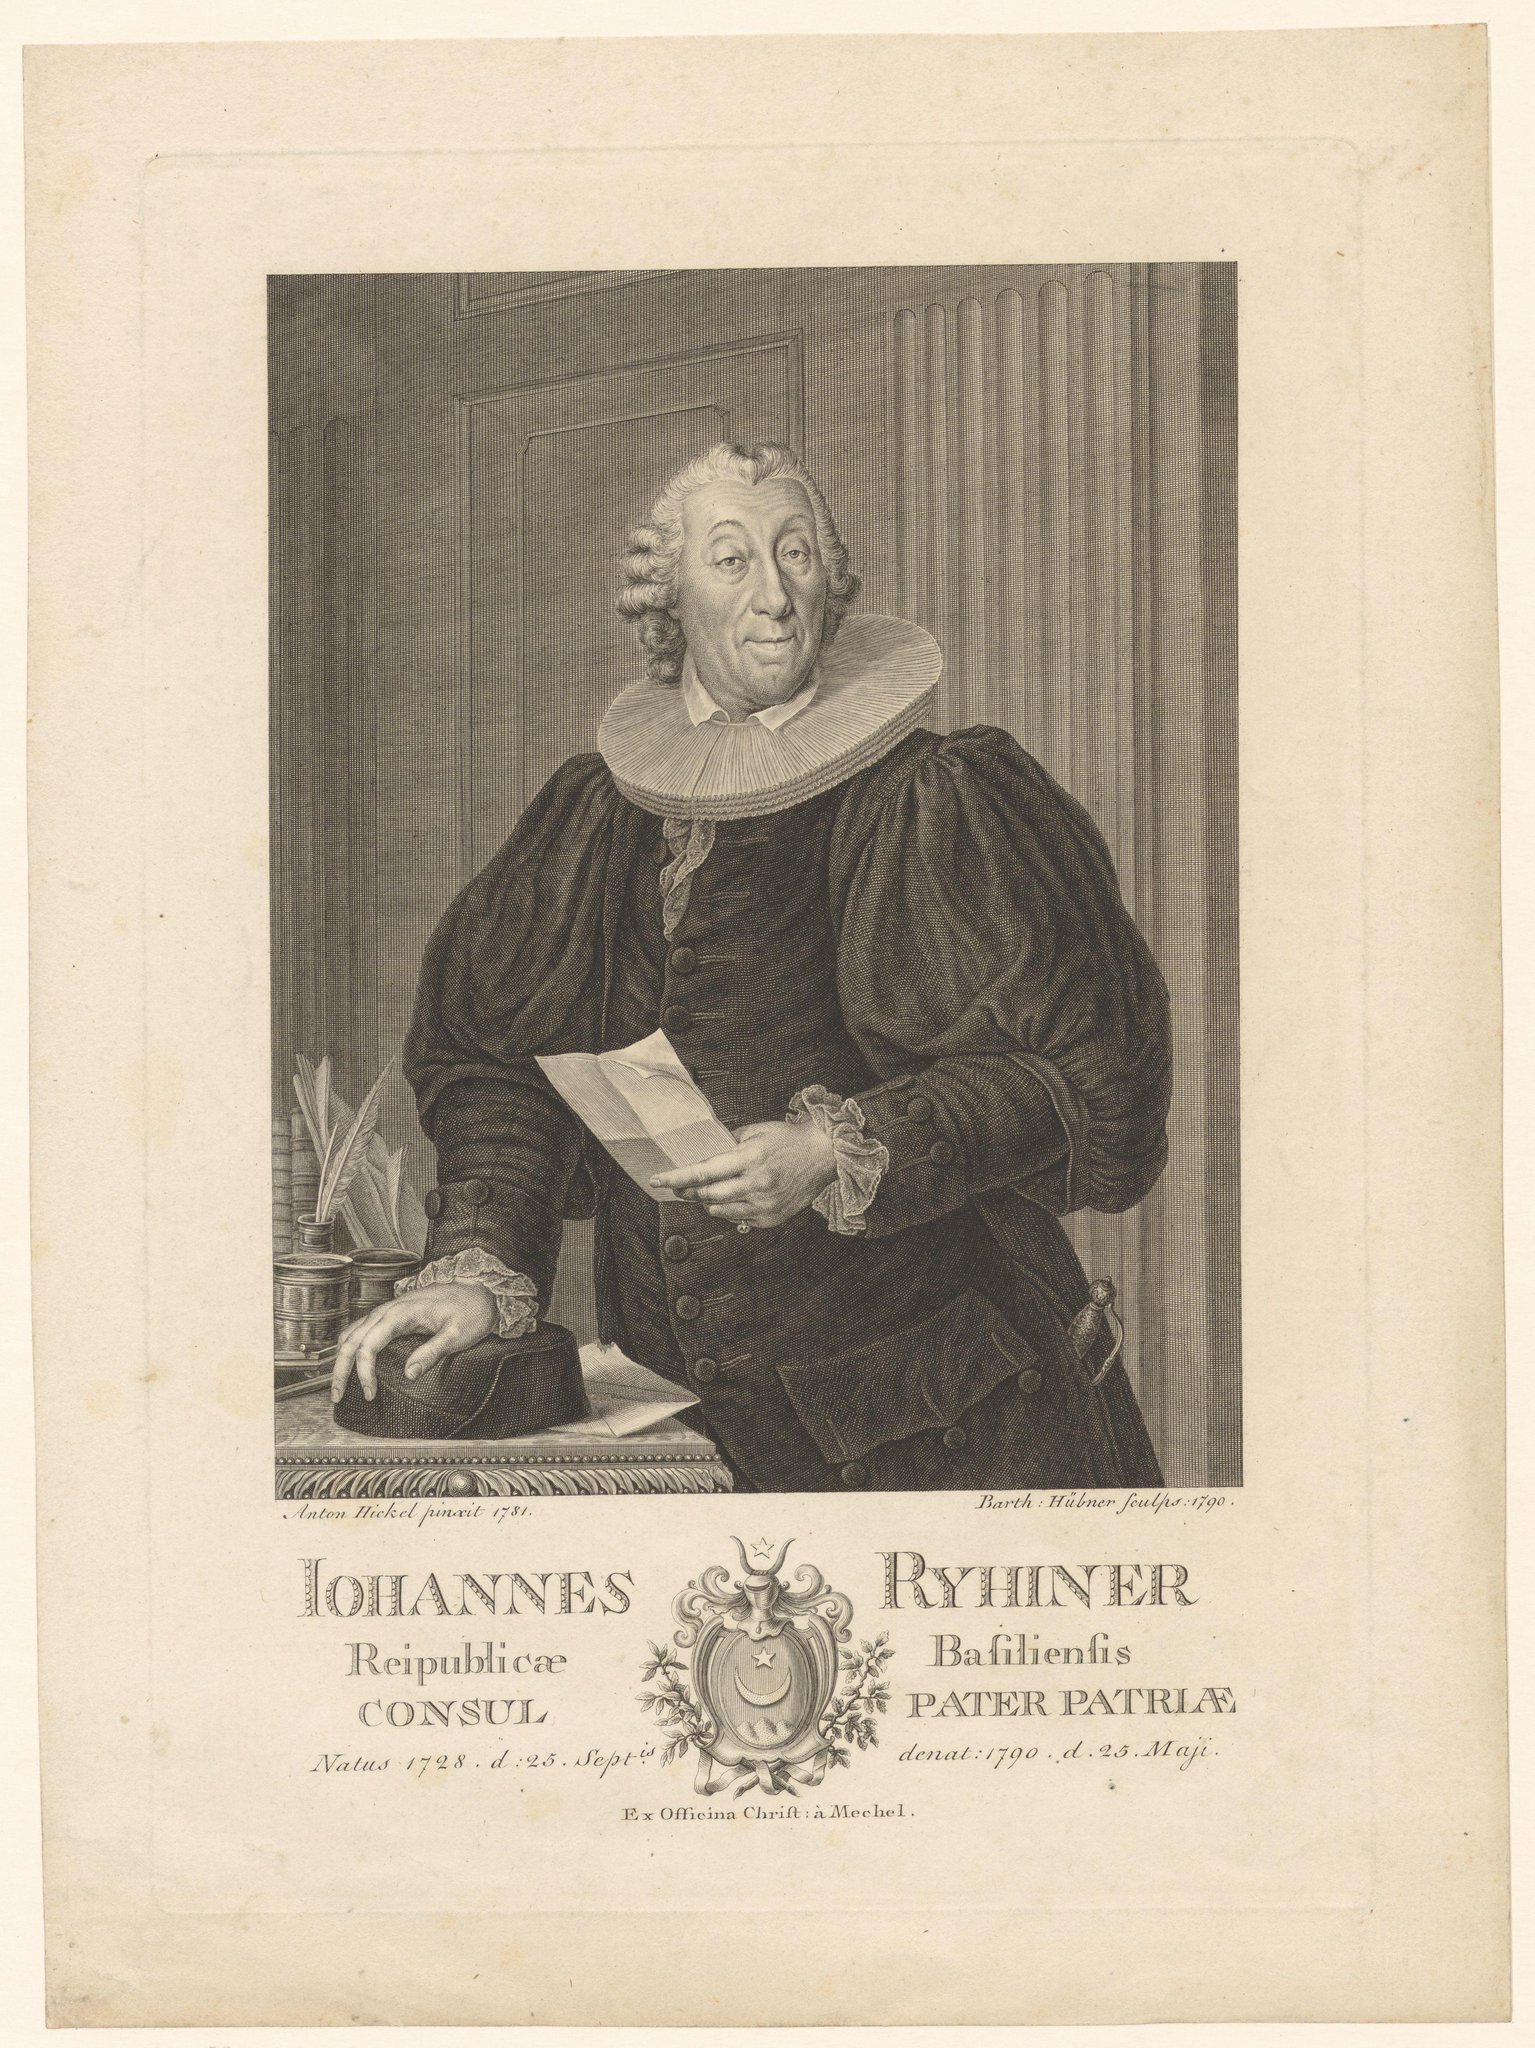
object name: print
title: Portret van Johannes Ryhiner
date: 1790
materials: paper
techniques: engraving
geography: basel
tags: mayor, writing tools, historical persons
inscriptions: signature: ‘Aman [...]’, collector's mark: Lugt 2228